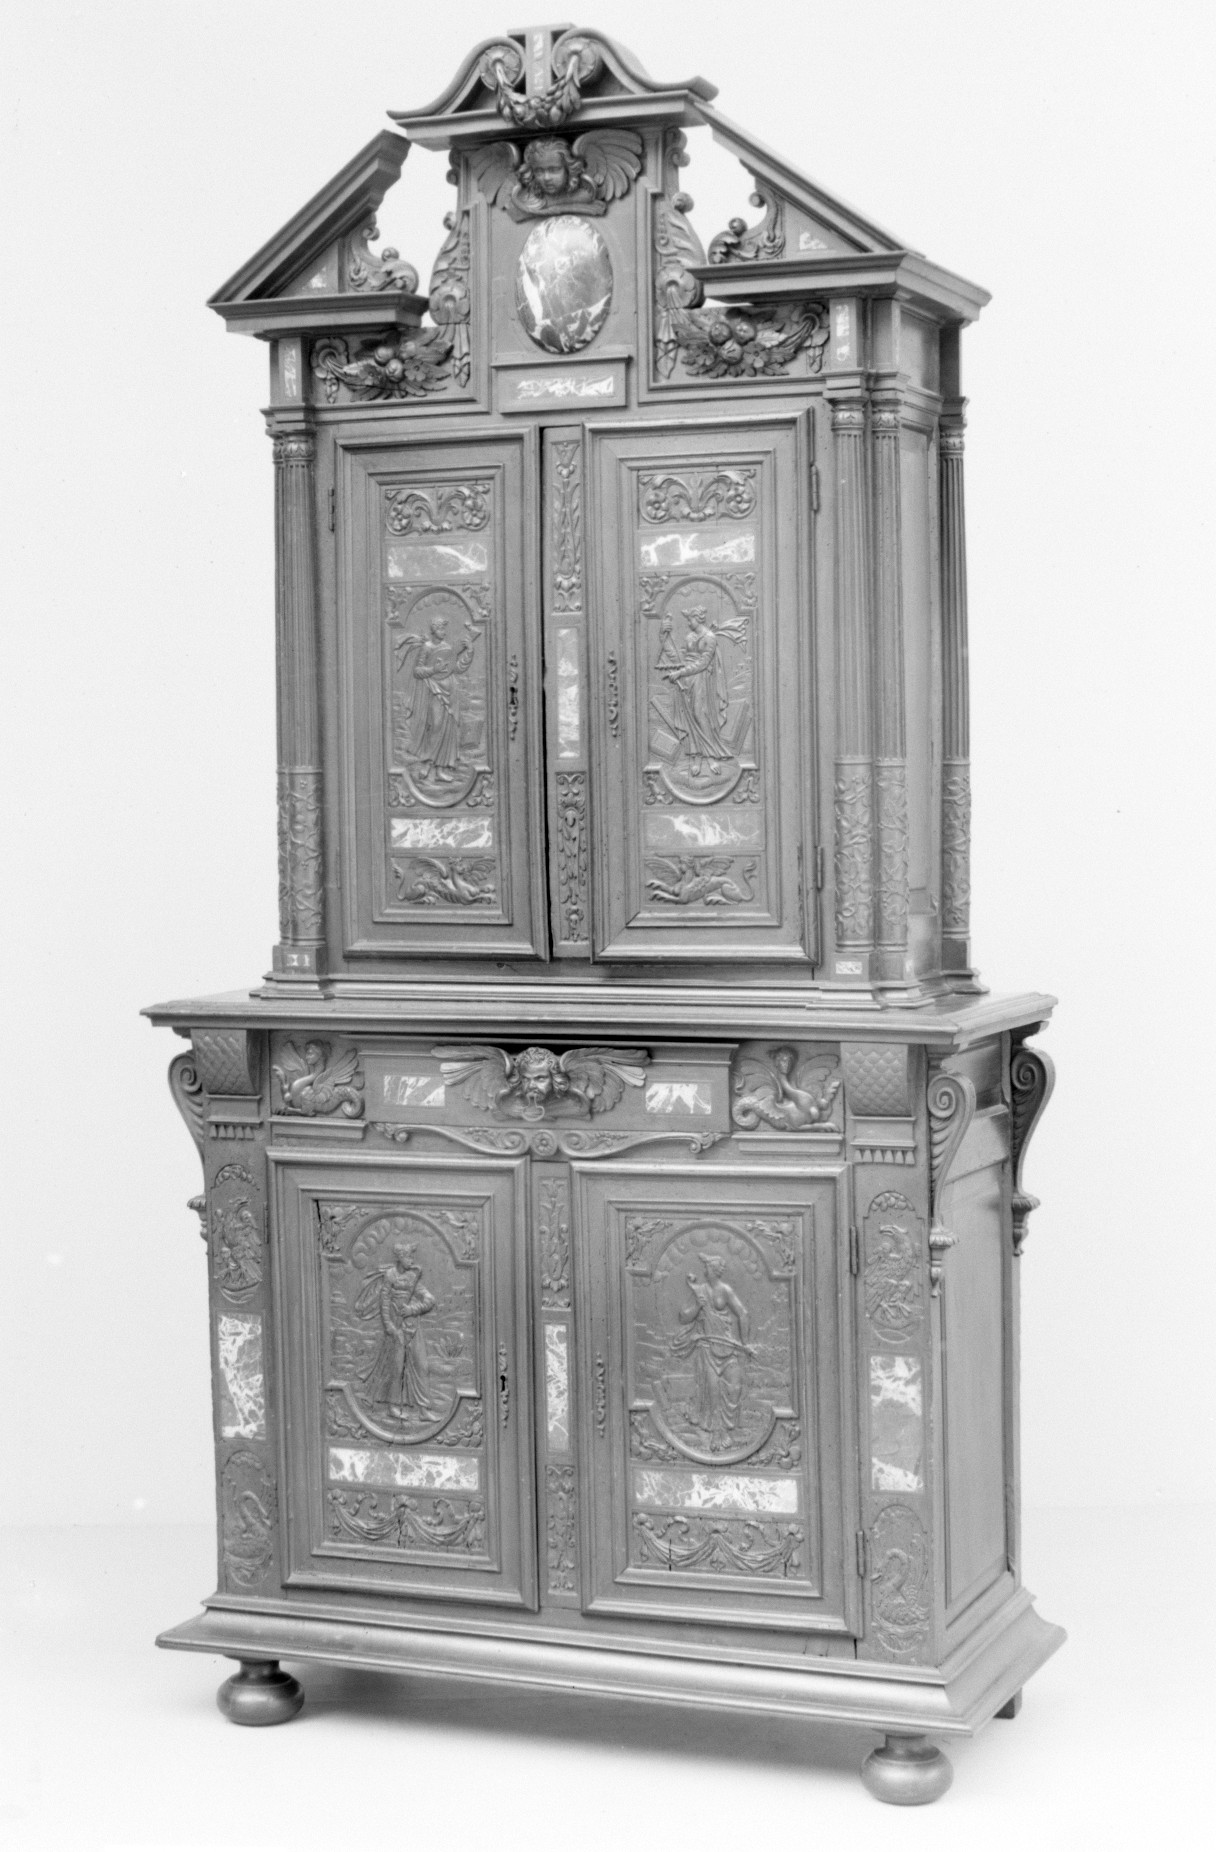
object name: cabinet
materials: marble, wood